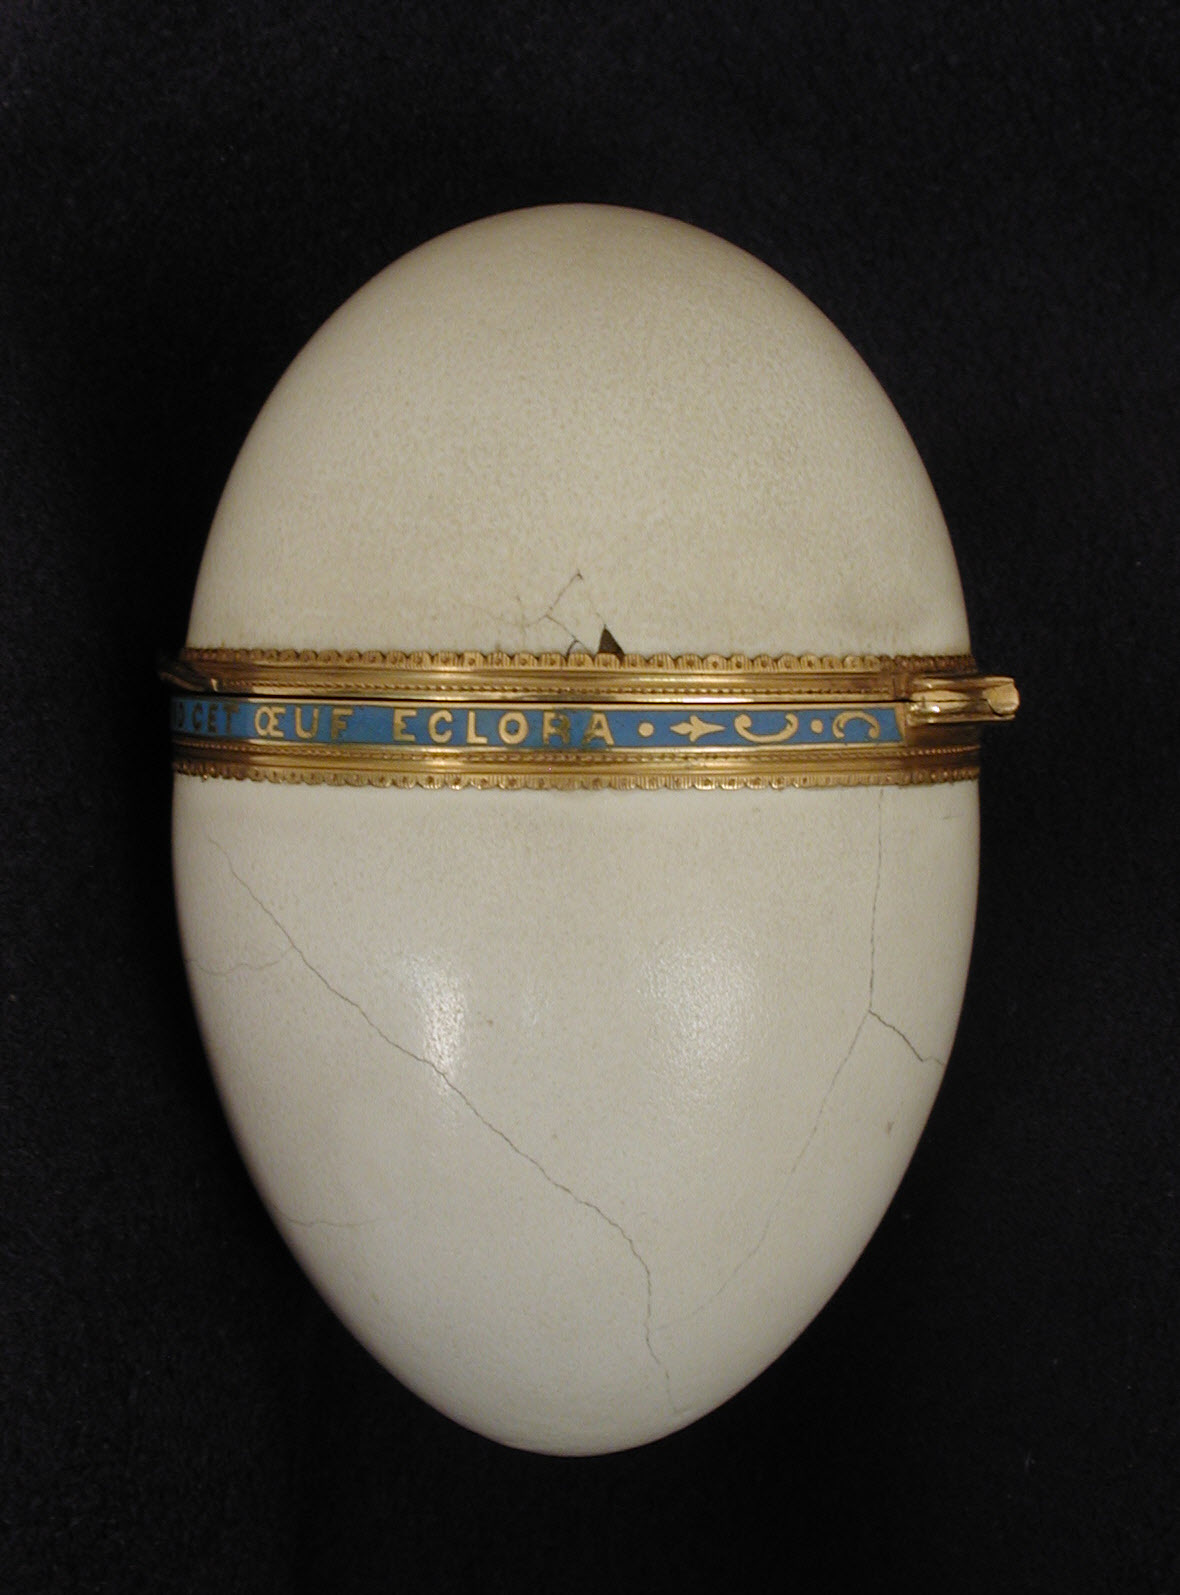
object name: nécessaire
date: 1801-1900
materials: enamel, glass, gold, ivory